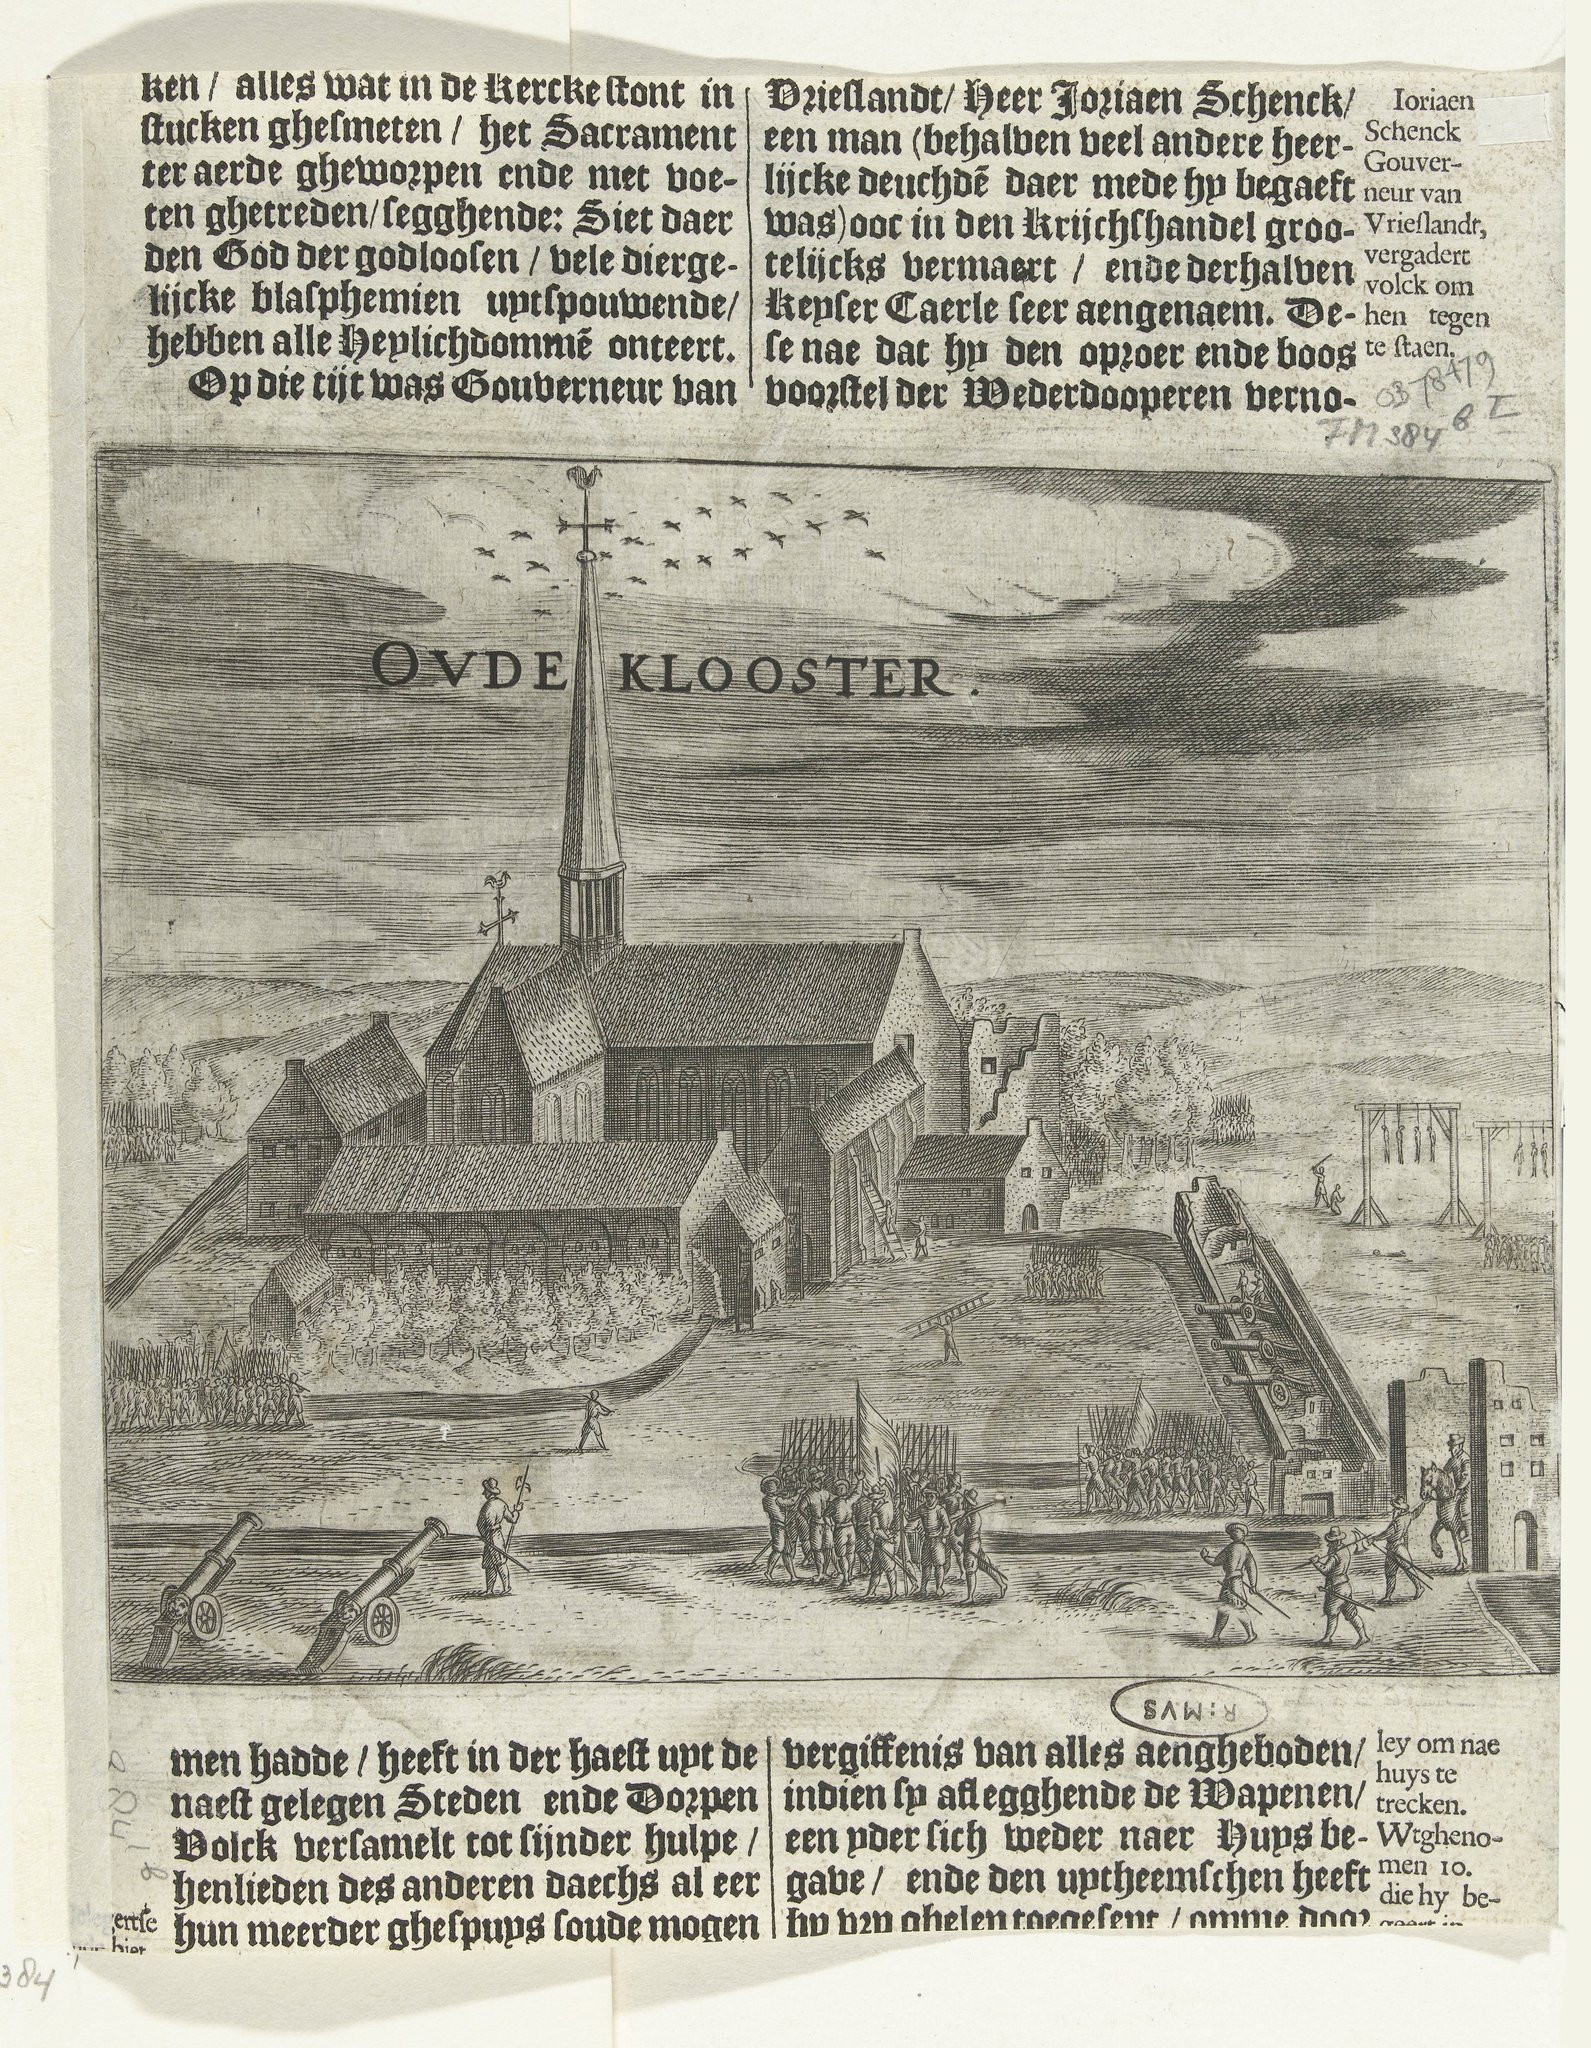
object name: print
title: Oudeklooster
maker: Anonymous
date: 1612-1614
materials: paper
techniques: engraving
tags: siege, position war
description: Het beleg van het door de wederdopers bezette Oldeklooster bij Bolsward door de troepen van stadhouder Georg Schenck, april 1535. Prent uit het boek geknipt.